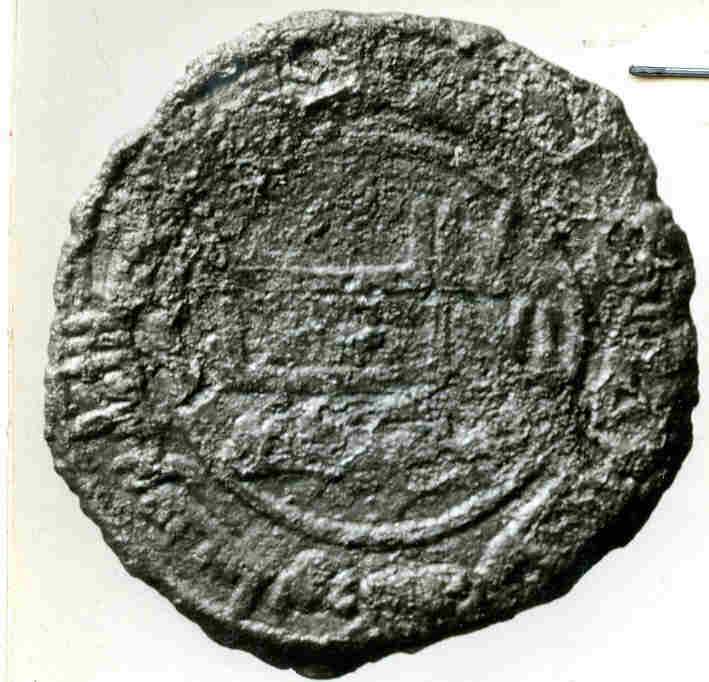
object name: coin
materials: copper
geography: iran